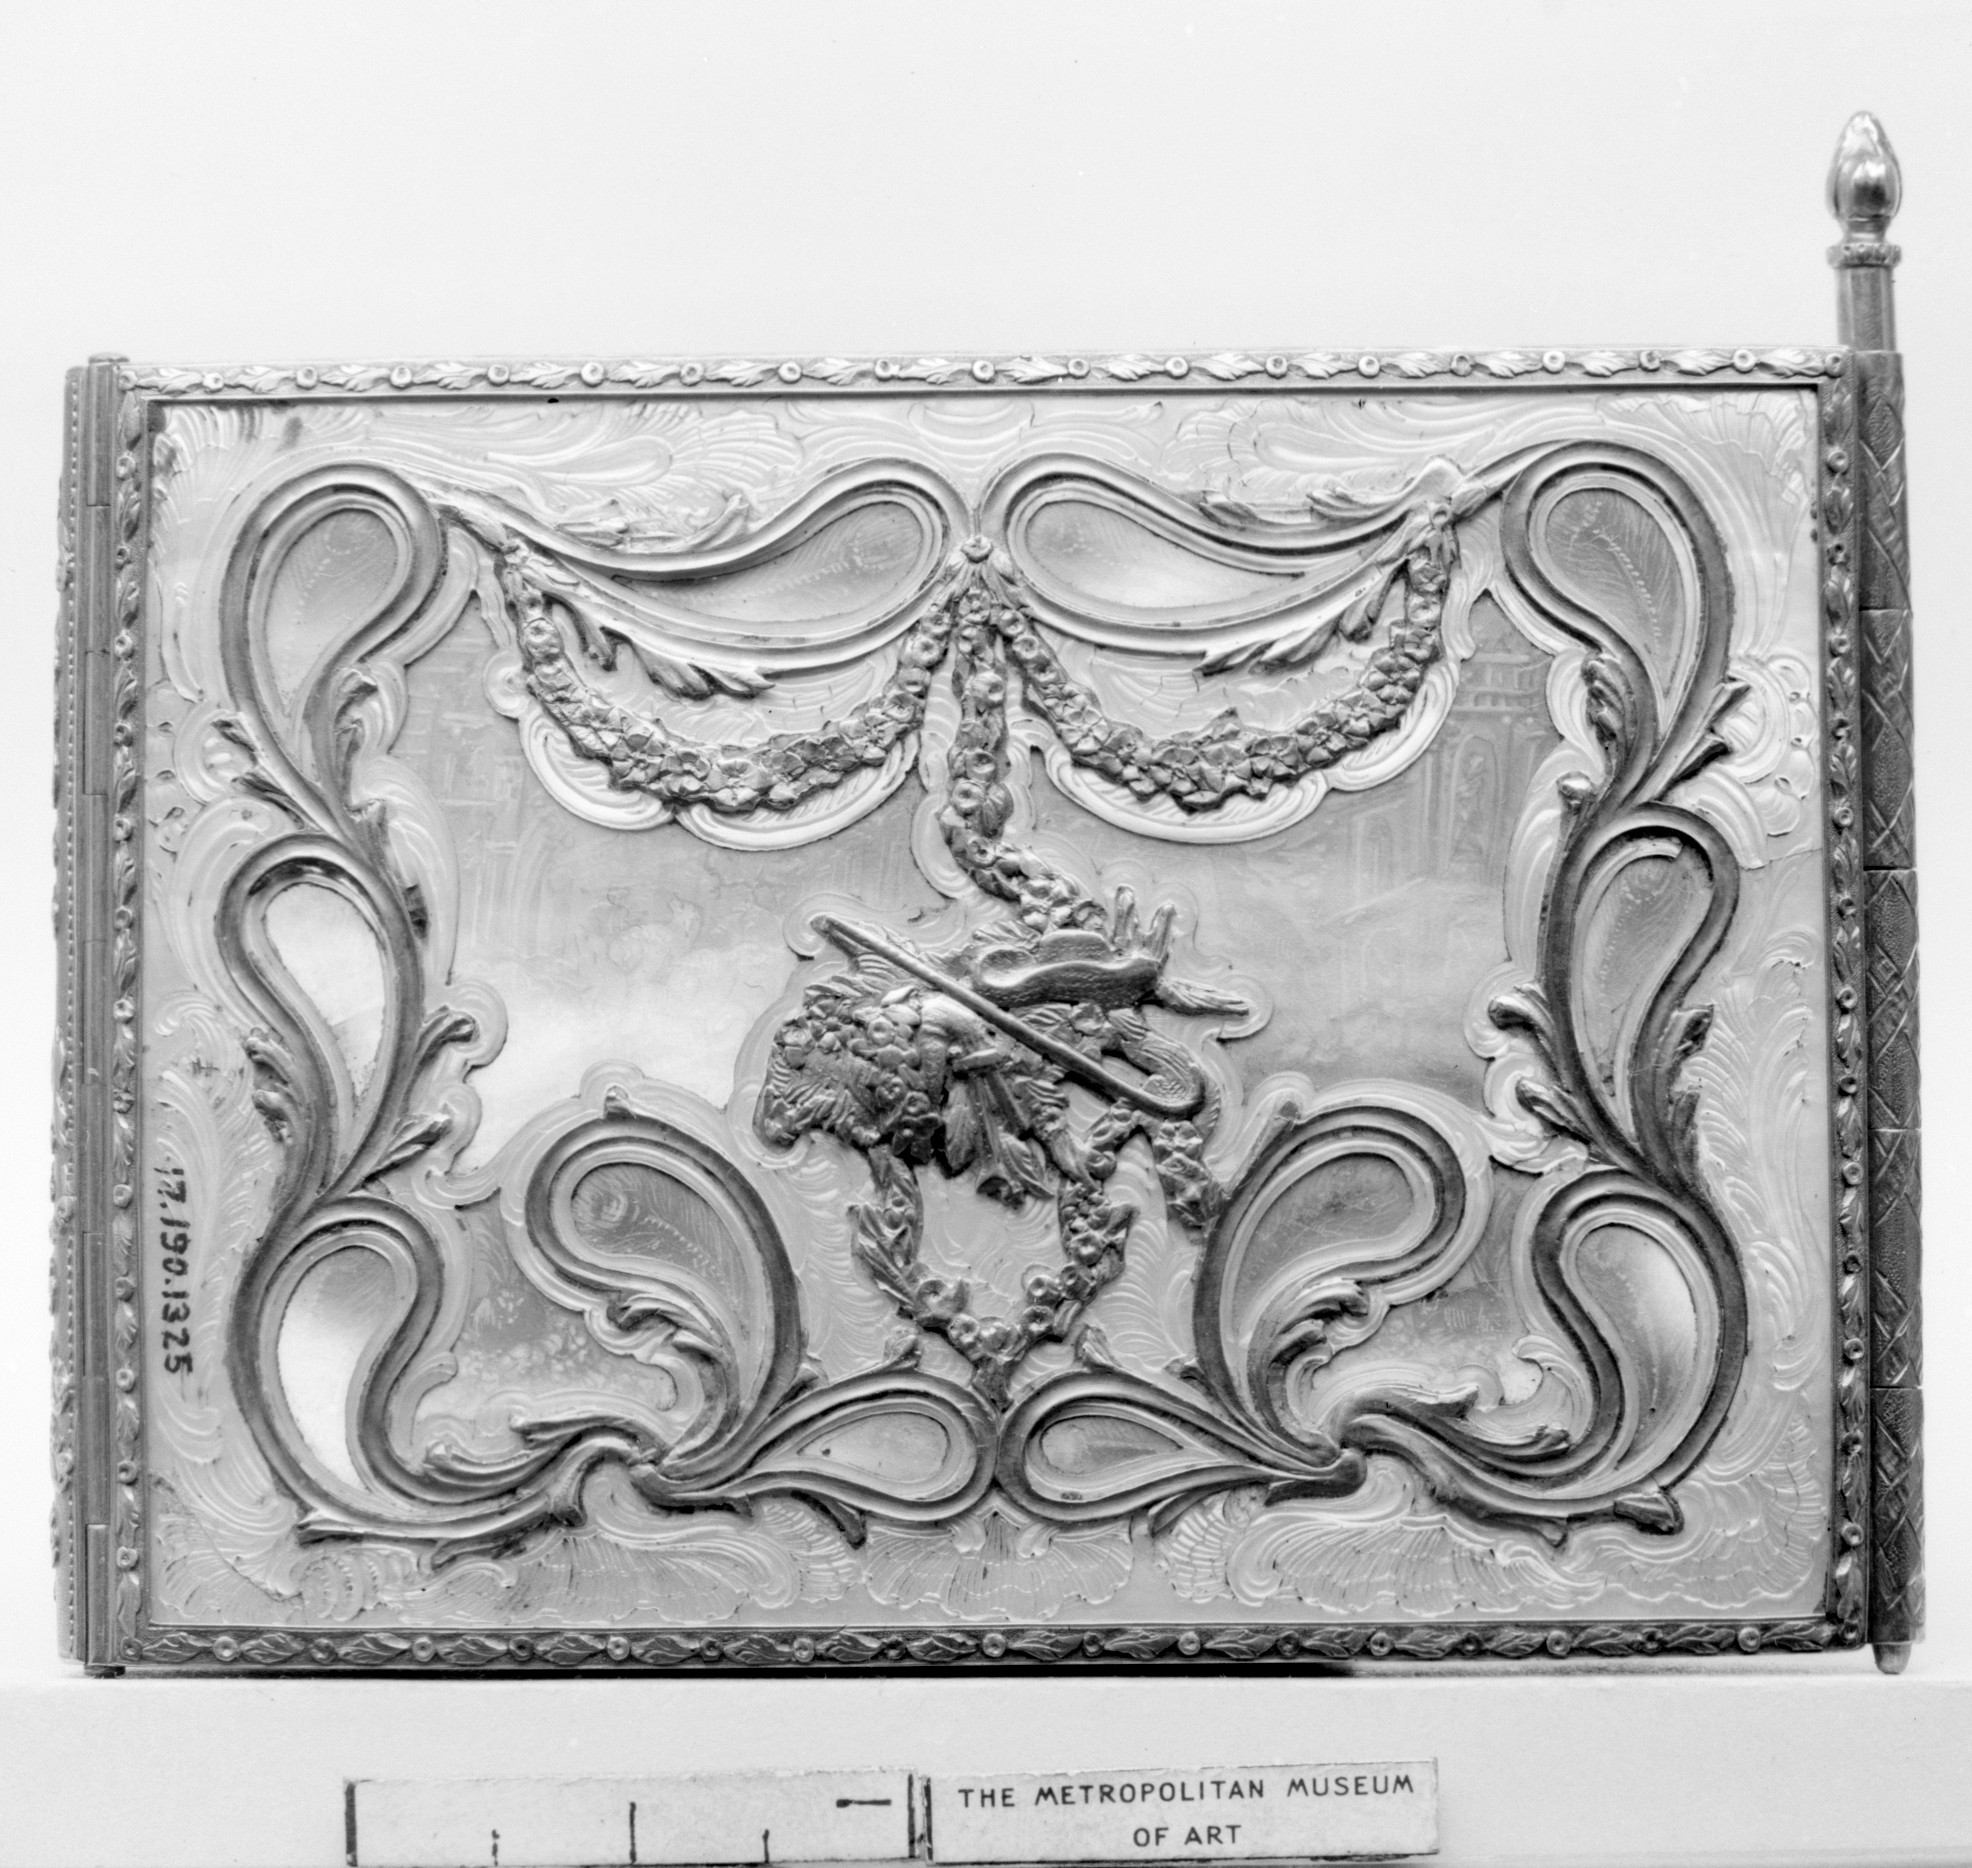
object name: notebook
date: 1801-1900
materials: gold, mother of pearl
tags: books